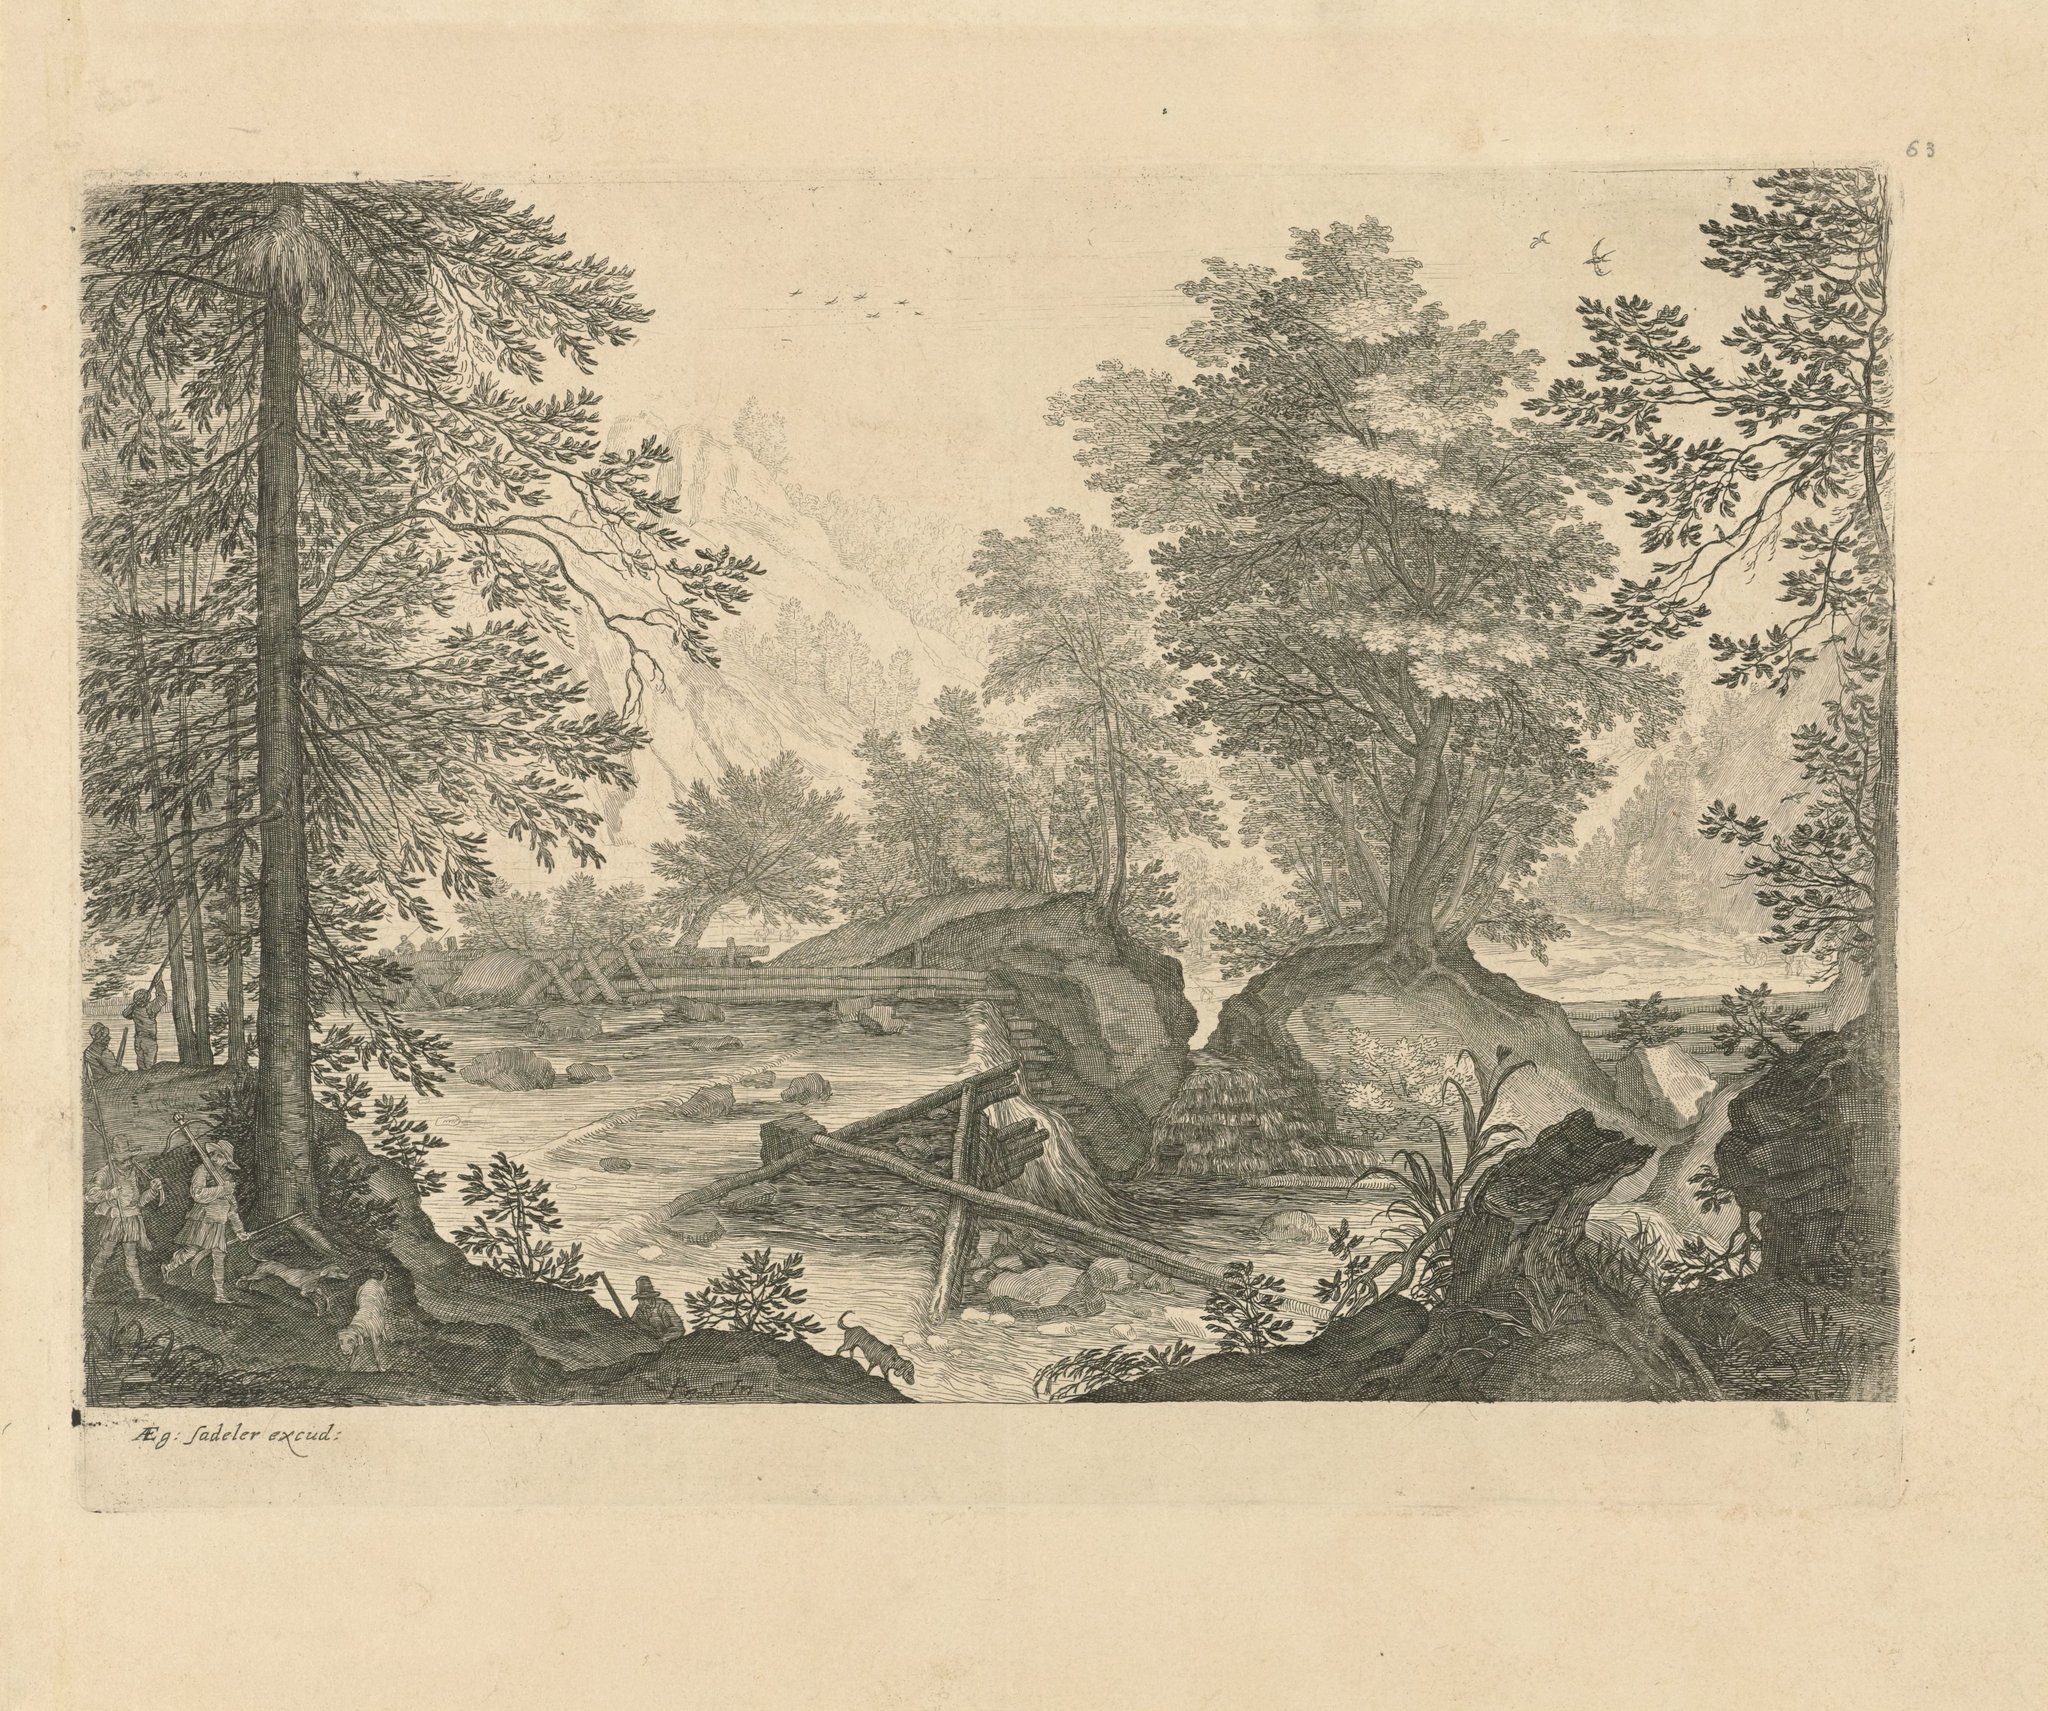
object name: print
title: Landschap met bergstroom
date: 1597-1629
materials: paper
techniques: engraving, etching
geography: prague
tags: waterfall, 'en route', traveller under way, mountains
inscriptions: collector's mark: Lugt 2228, collector's mark: Lugt 2760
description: Een landschap met op de voorgrond enkele reizigers. Op de achtergrond een bergrivier met waterval. De tweede prent van een achtdelige reeks met Boheemse landschappen.